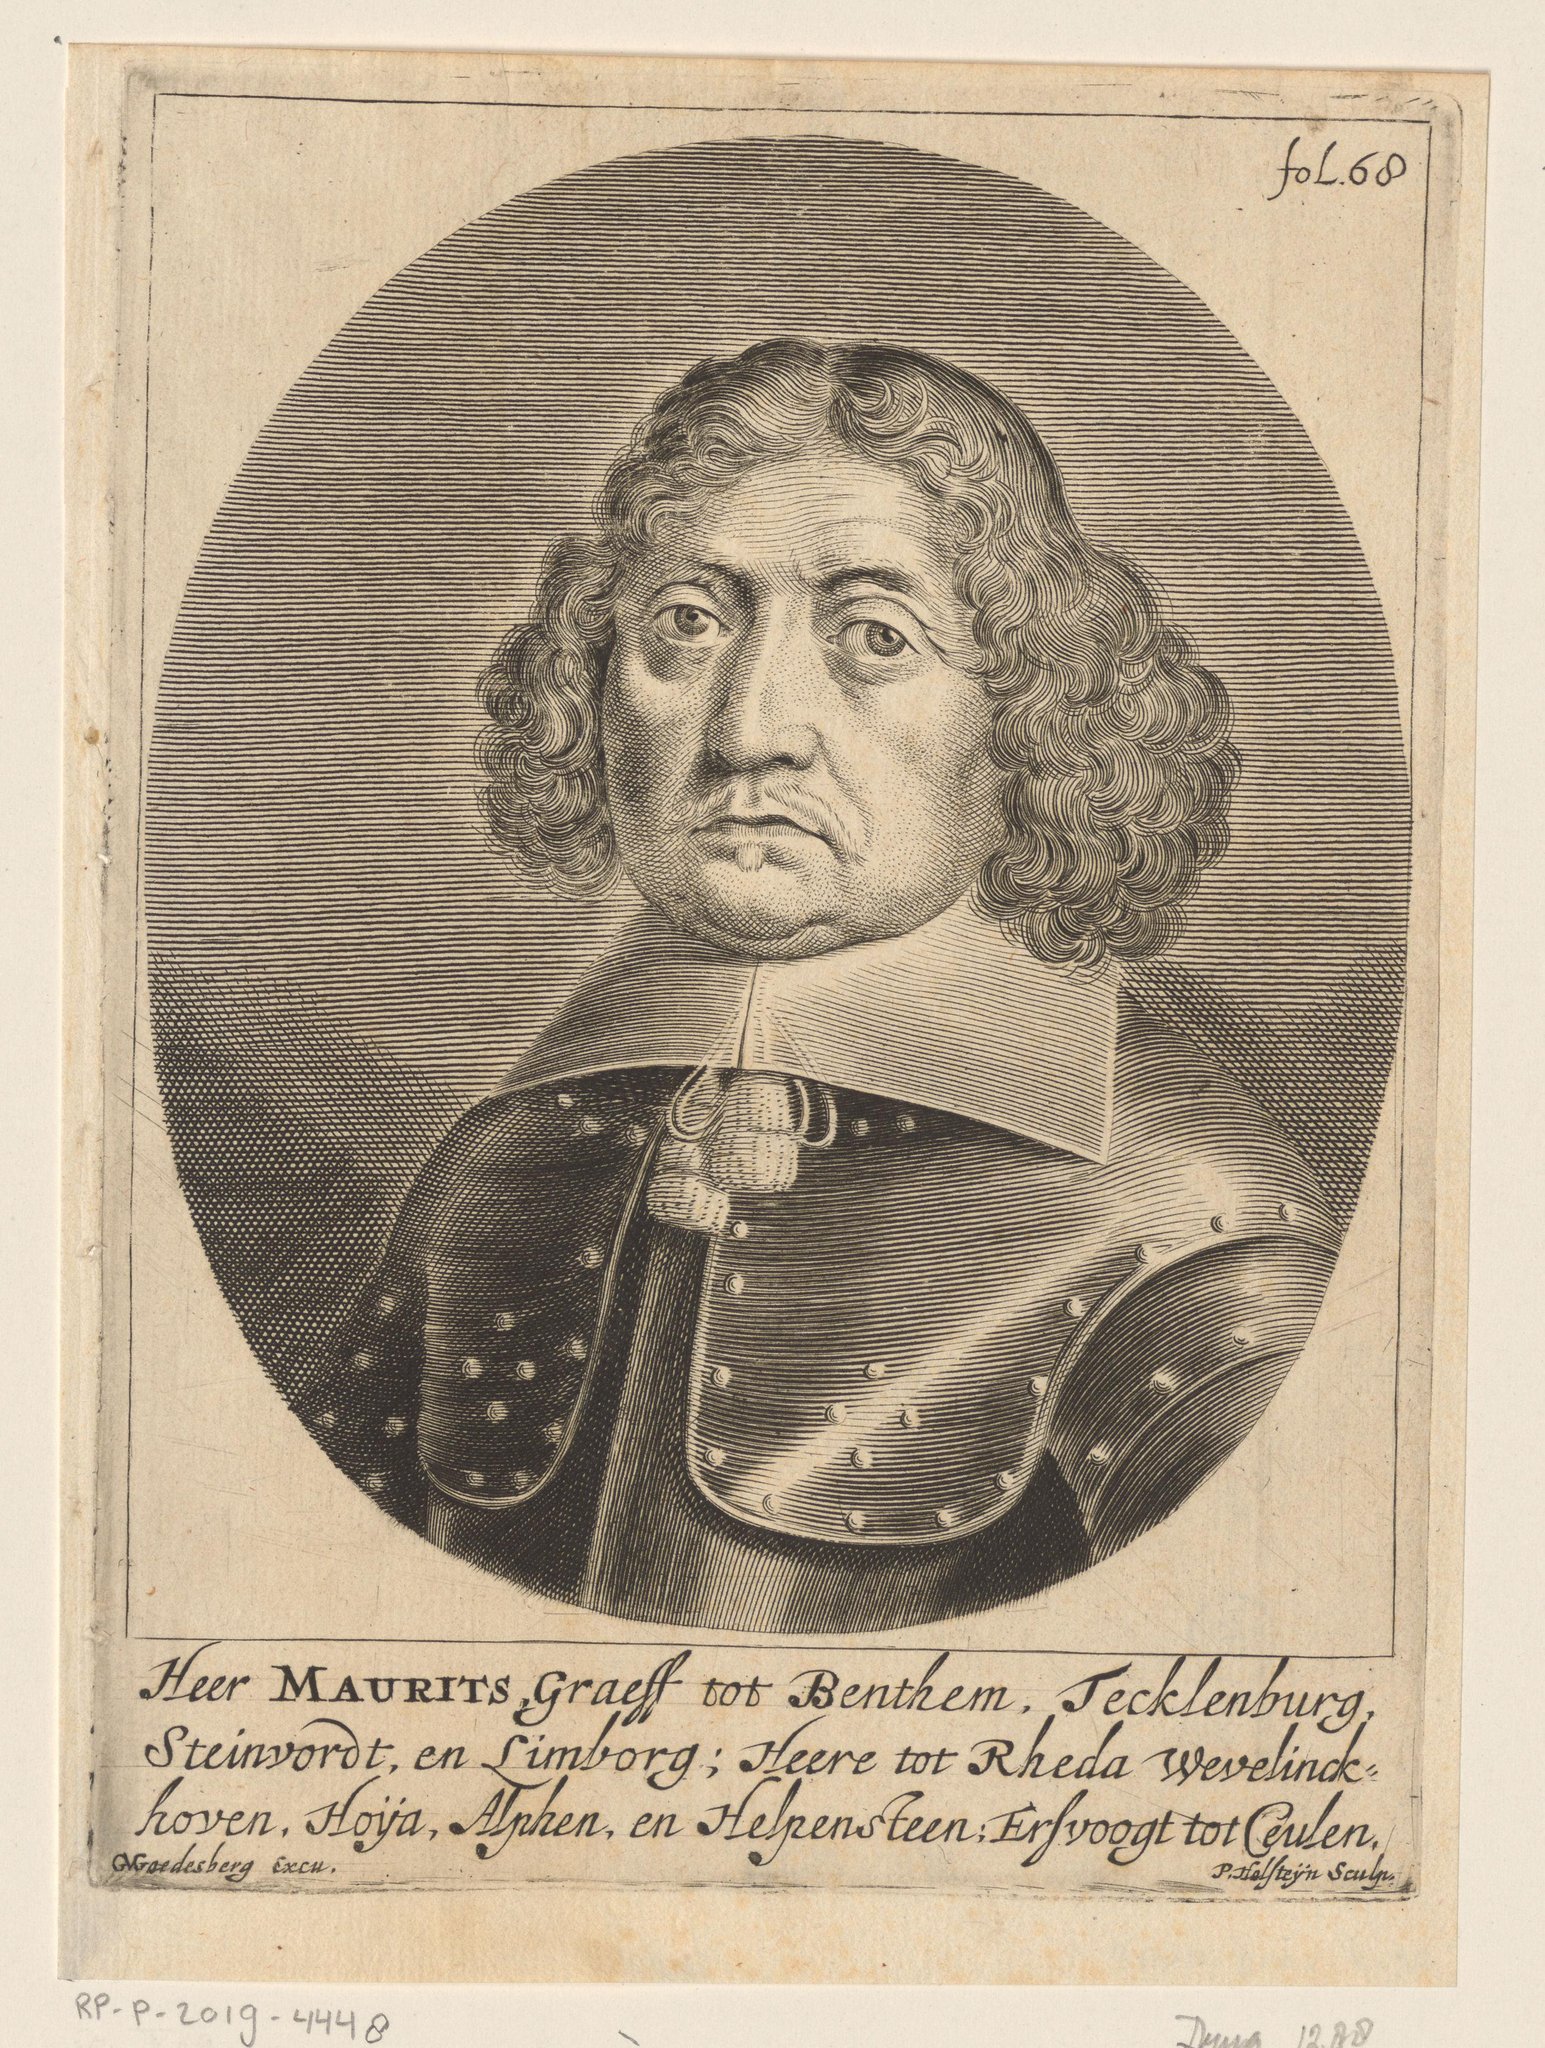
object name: print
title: Portret van Maurits, graaf van Bentheim-Tecklenburg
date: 1660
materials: paper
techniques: engraving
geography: amsterdam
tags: armour, historical persons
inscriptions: collector's mark: Lugt 964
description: Prent uit: Picardt, Johan. Korte beschryvinge van eenige vergetene en verborgene antiquiteten der provintien en landen gelegen tusschen de Noord-zee, de Yssel, Emse en Lippe. Amsterdam: Gerrit van Goedesberg en Tymon Houthaeck, 1660, p. 94.